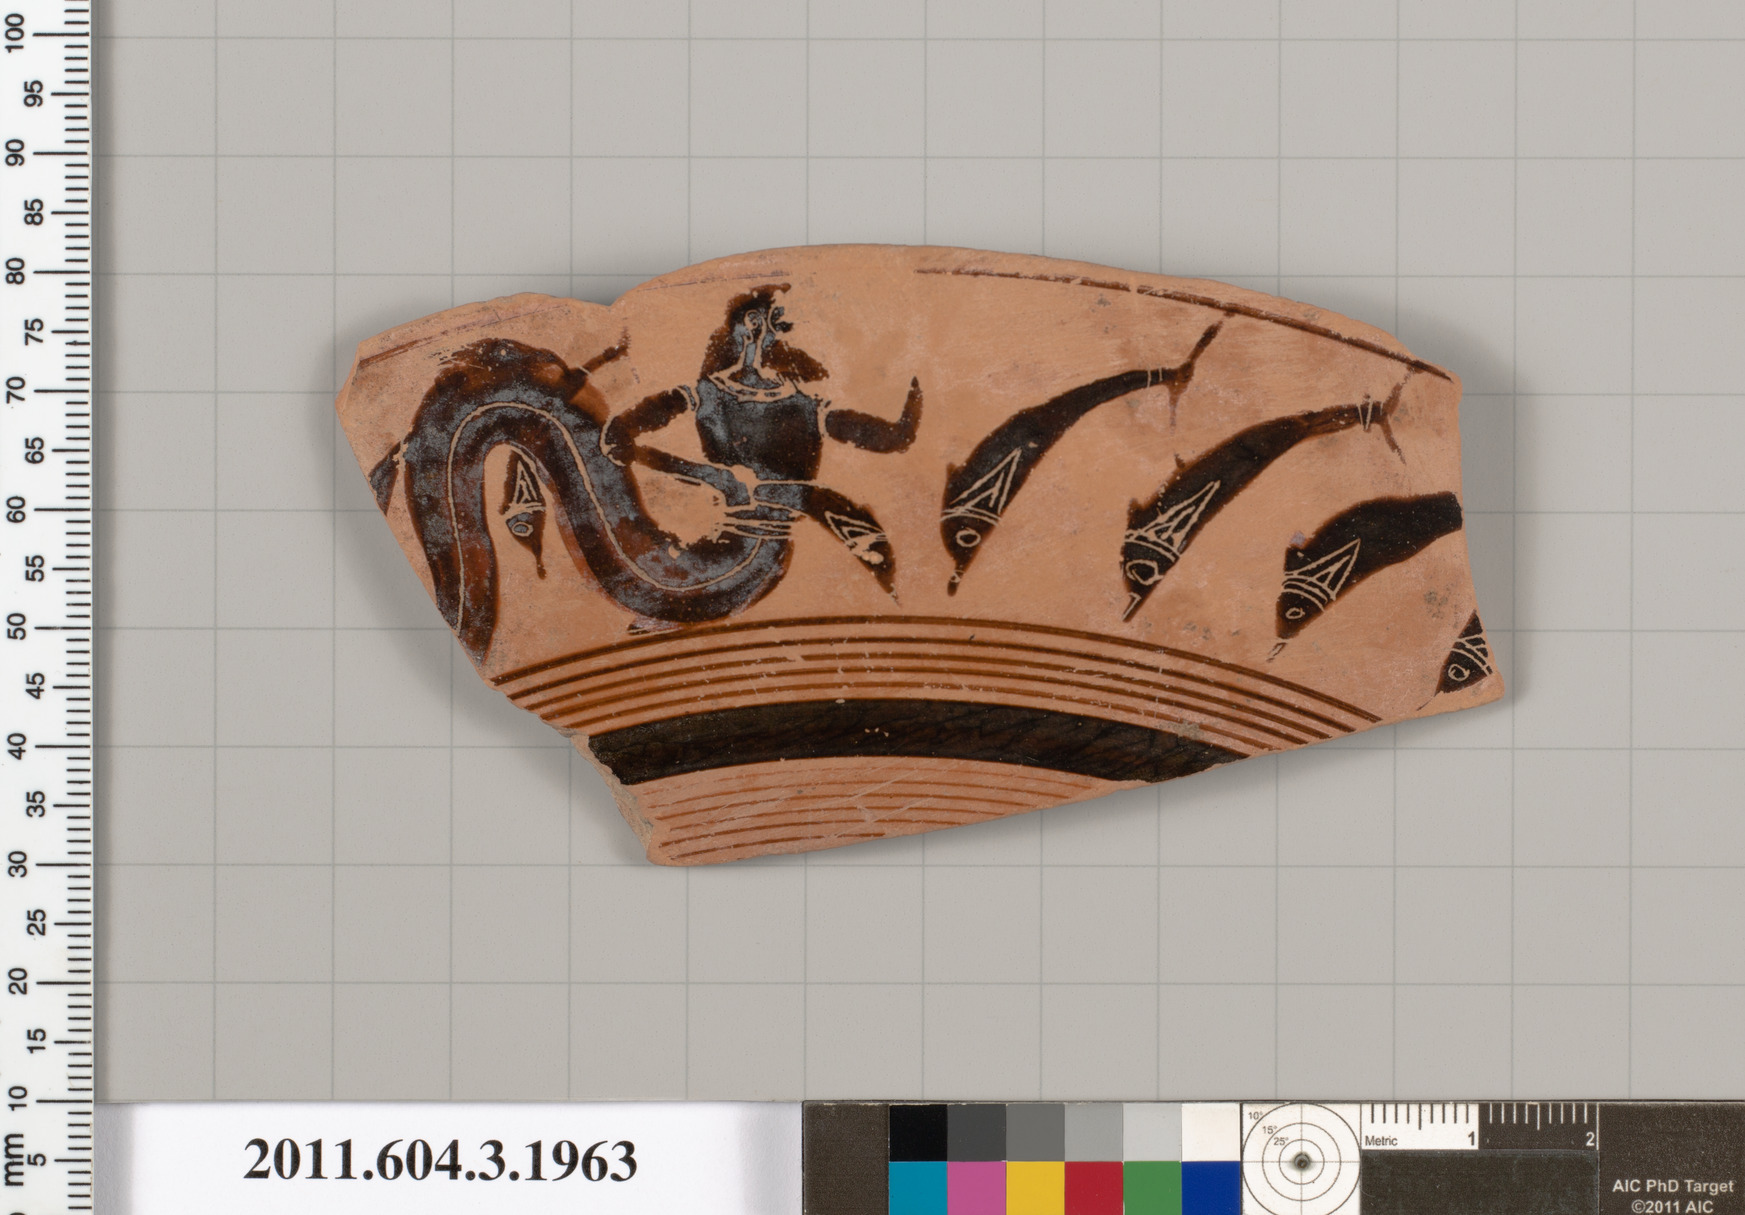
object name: kylix fragment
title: Terracotta fragment of a kylix (drinking cup)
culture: greek, attic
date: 567-535 BCE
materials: terracotta